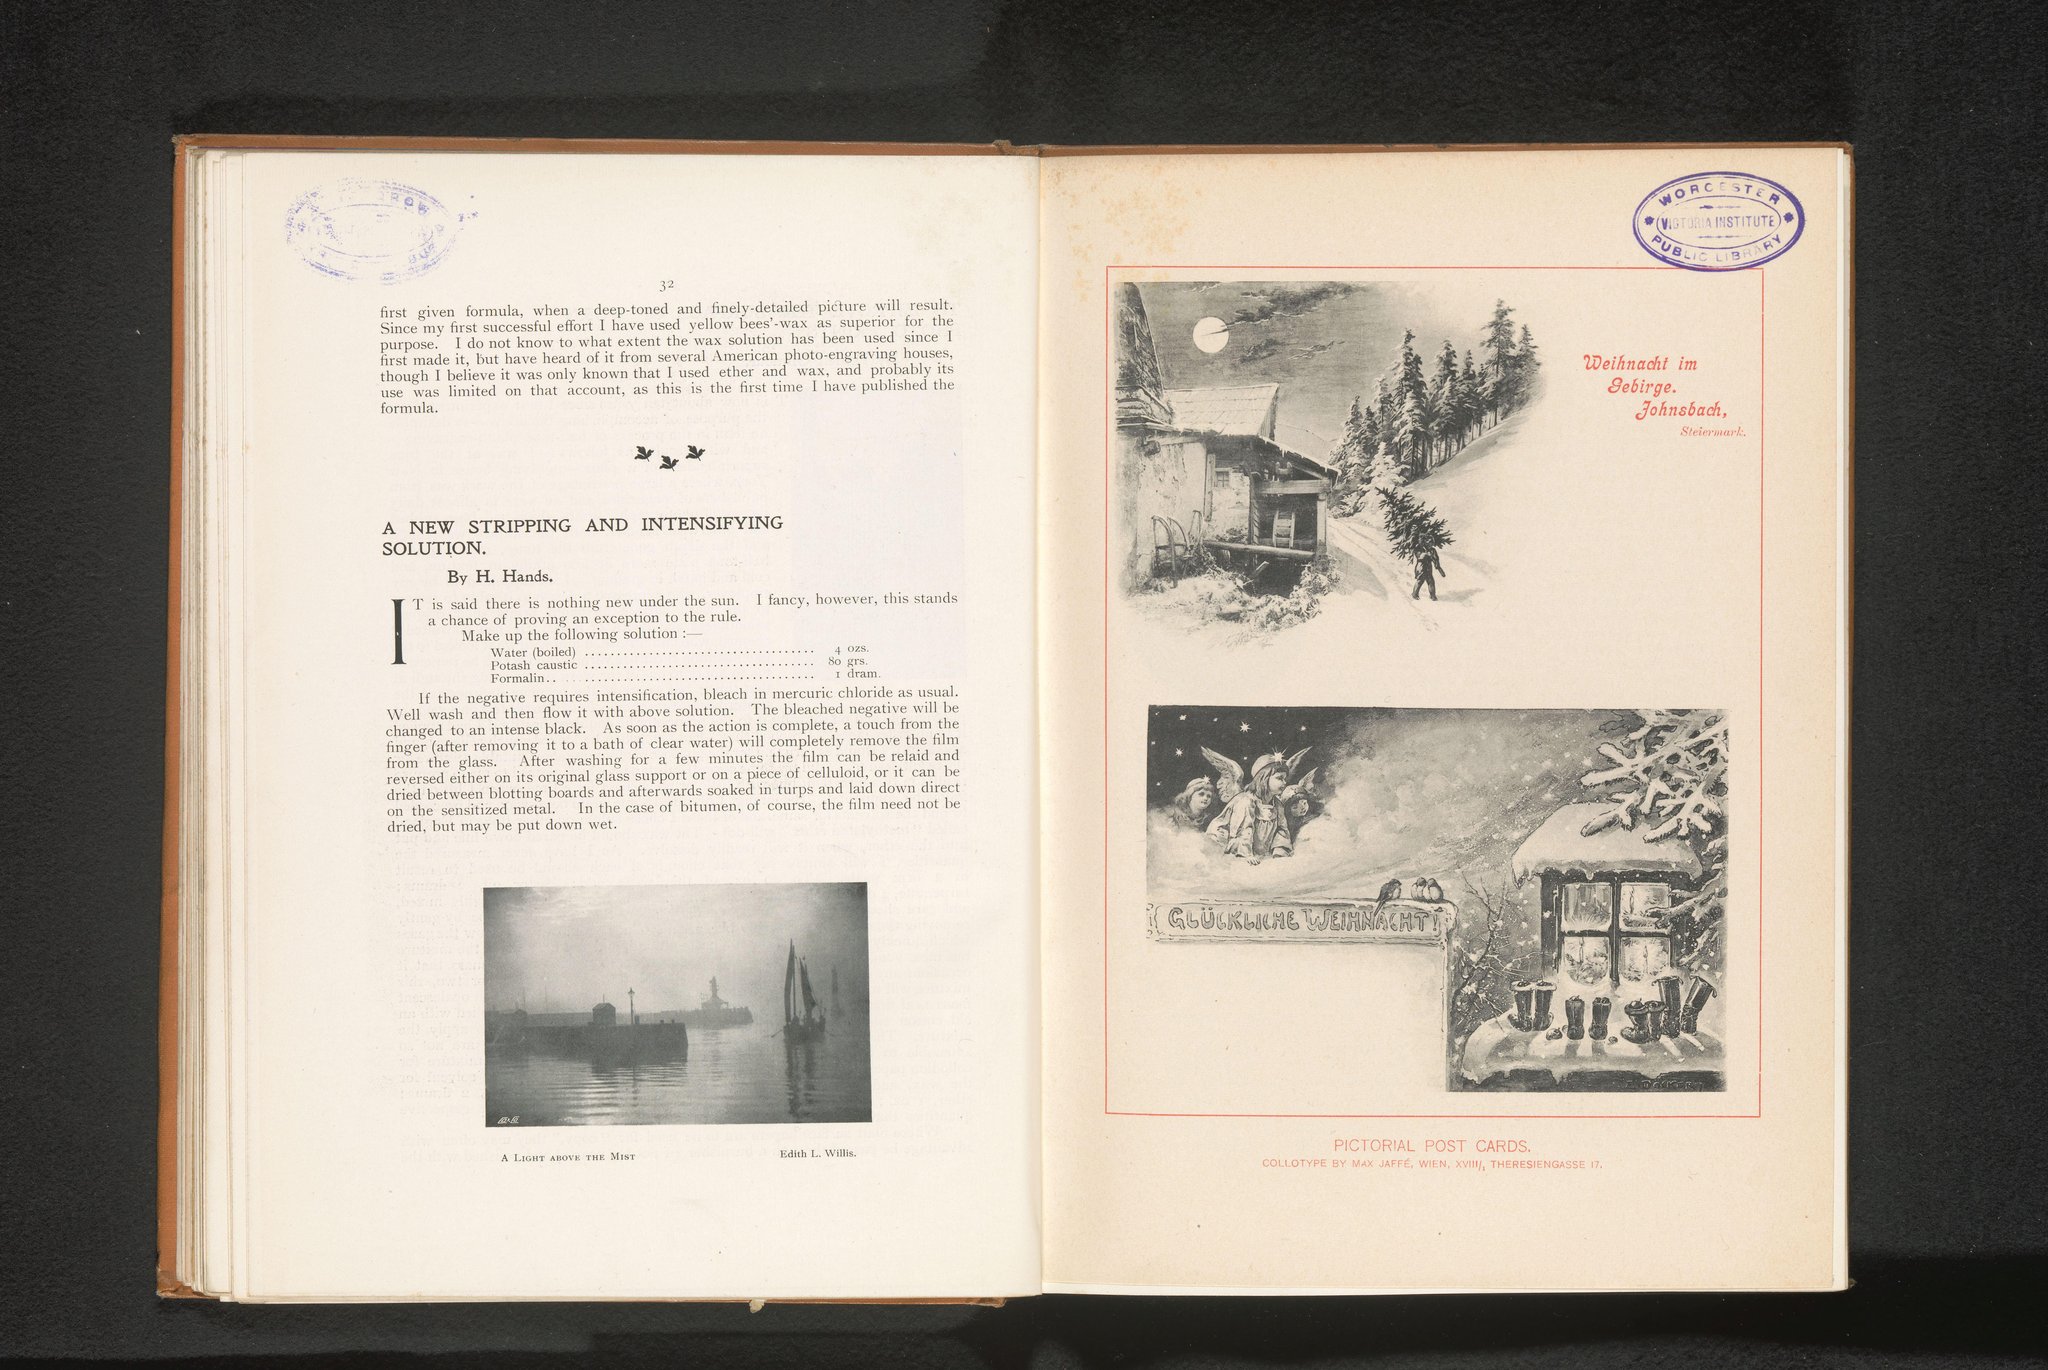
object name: page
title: Reproductie van twee kerstkaarten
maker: max jaffé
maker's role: painter, printer, publisher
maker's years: 1845-1939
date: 1894-1899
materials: paper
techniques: photograph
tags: christmas card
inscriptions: collector's mark: ‘Worcester Public Library/ Victoria's Institute’